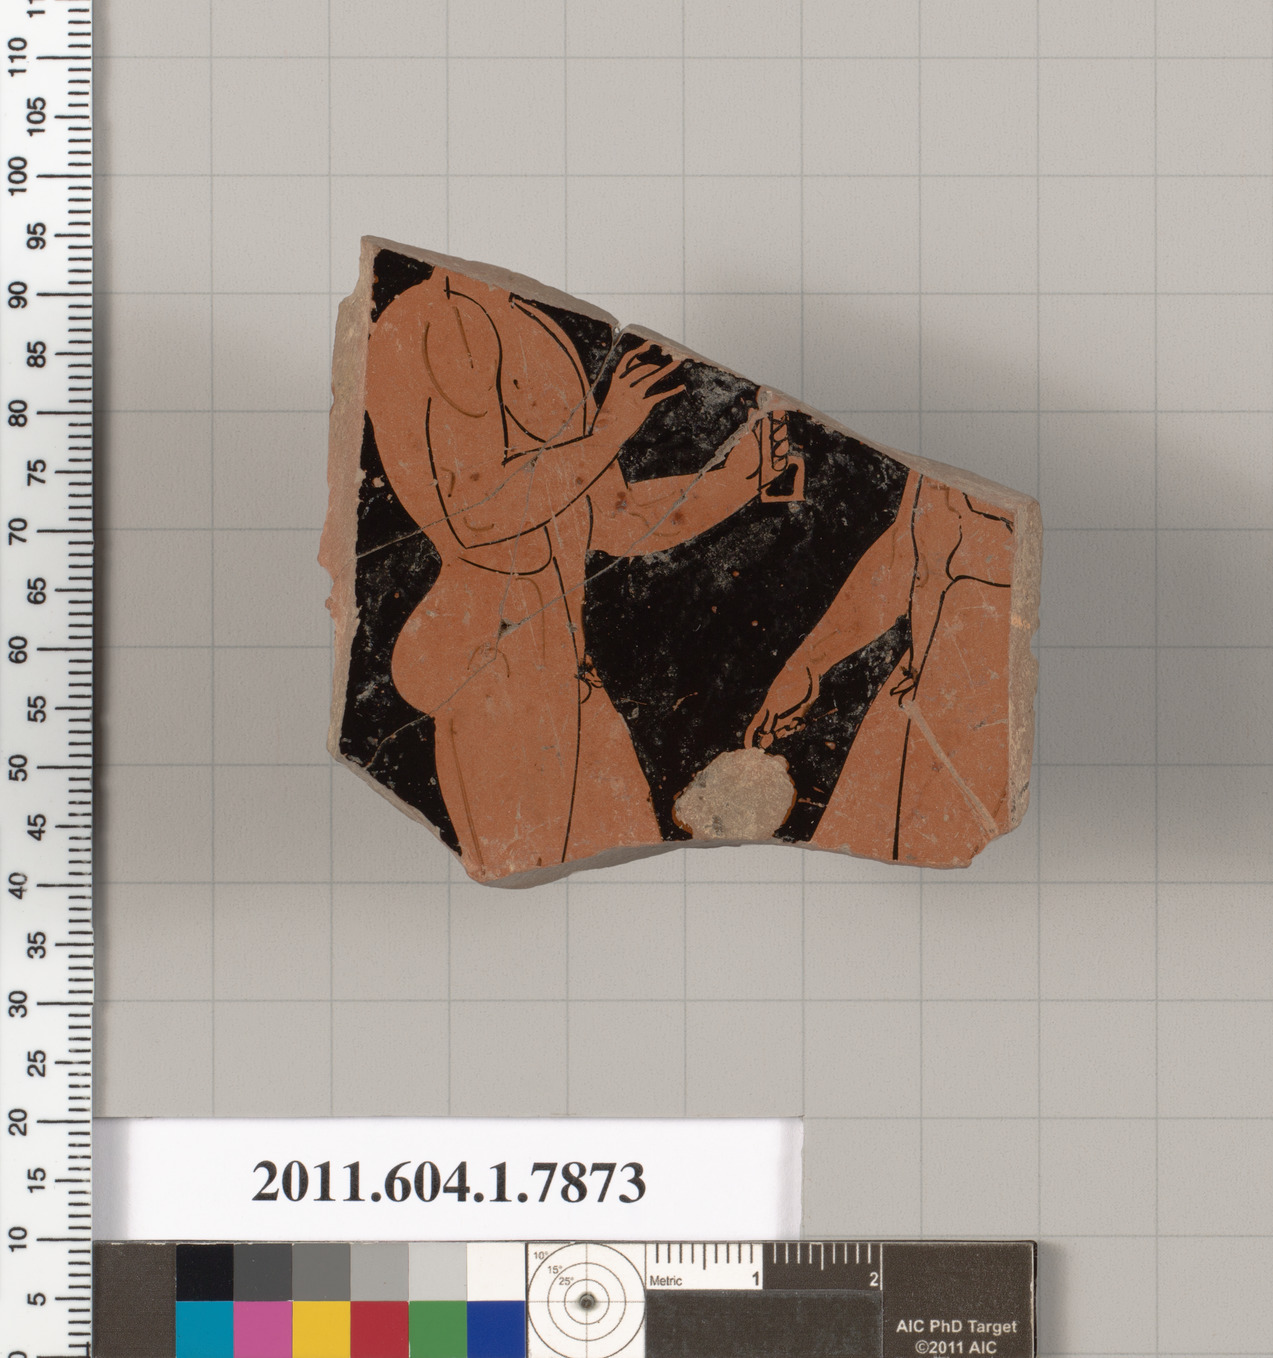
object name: kylix fragment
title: Terracotta fragment of a kylix (drinking cup)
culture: greek, attic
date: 440-420 BCE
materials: terracotta